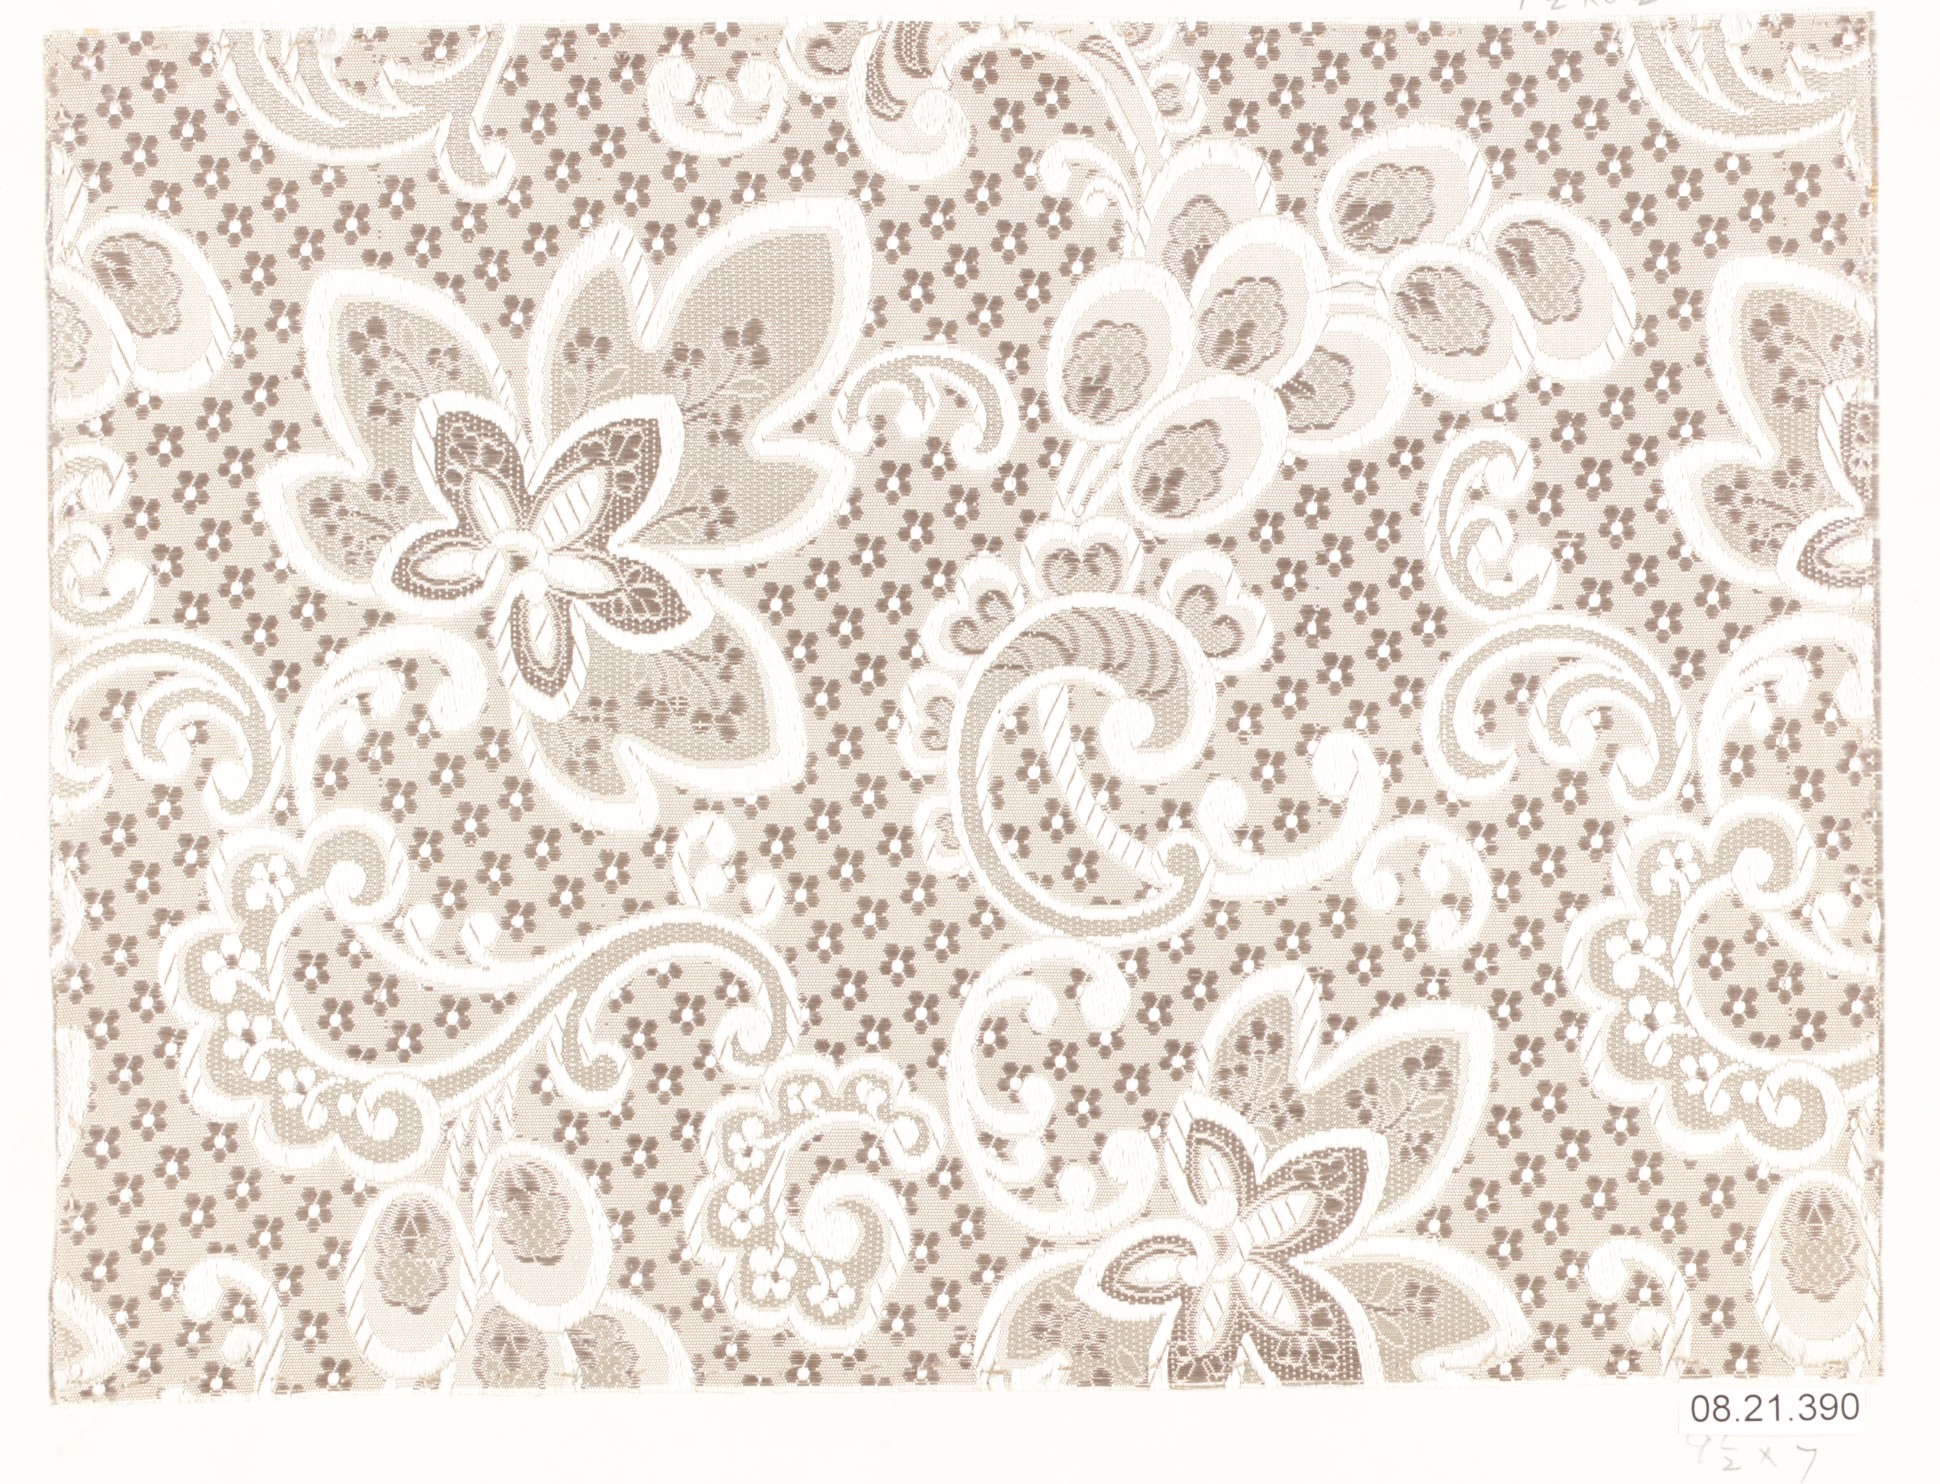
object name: textile sample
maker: Anonymous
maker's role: designer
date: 1900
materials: silk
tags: flowers